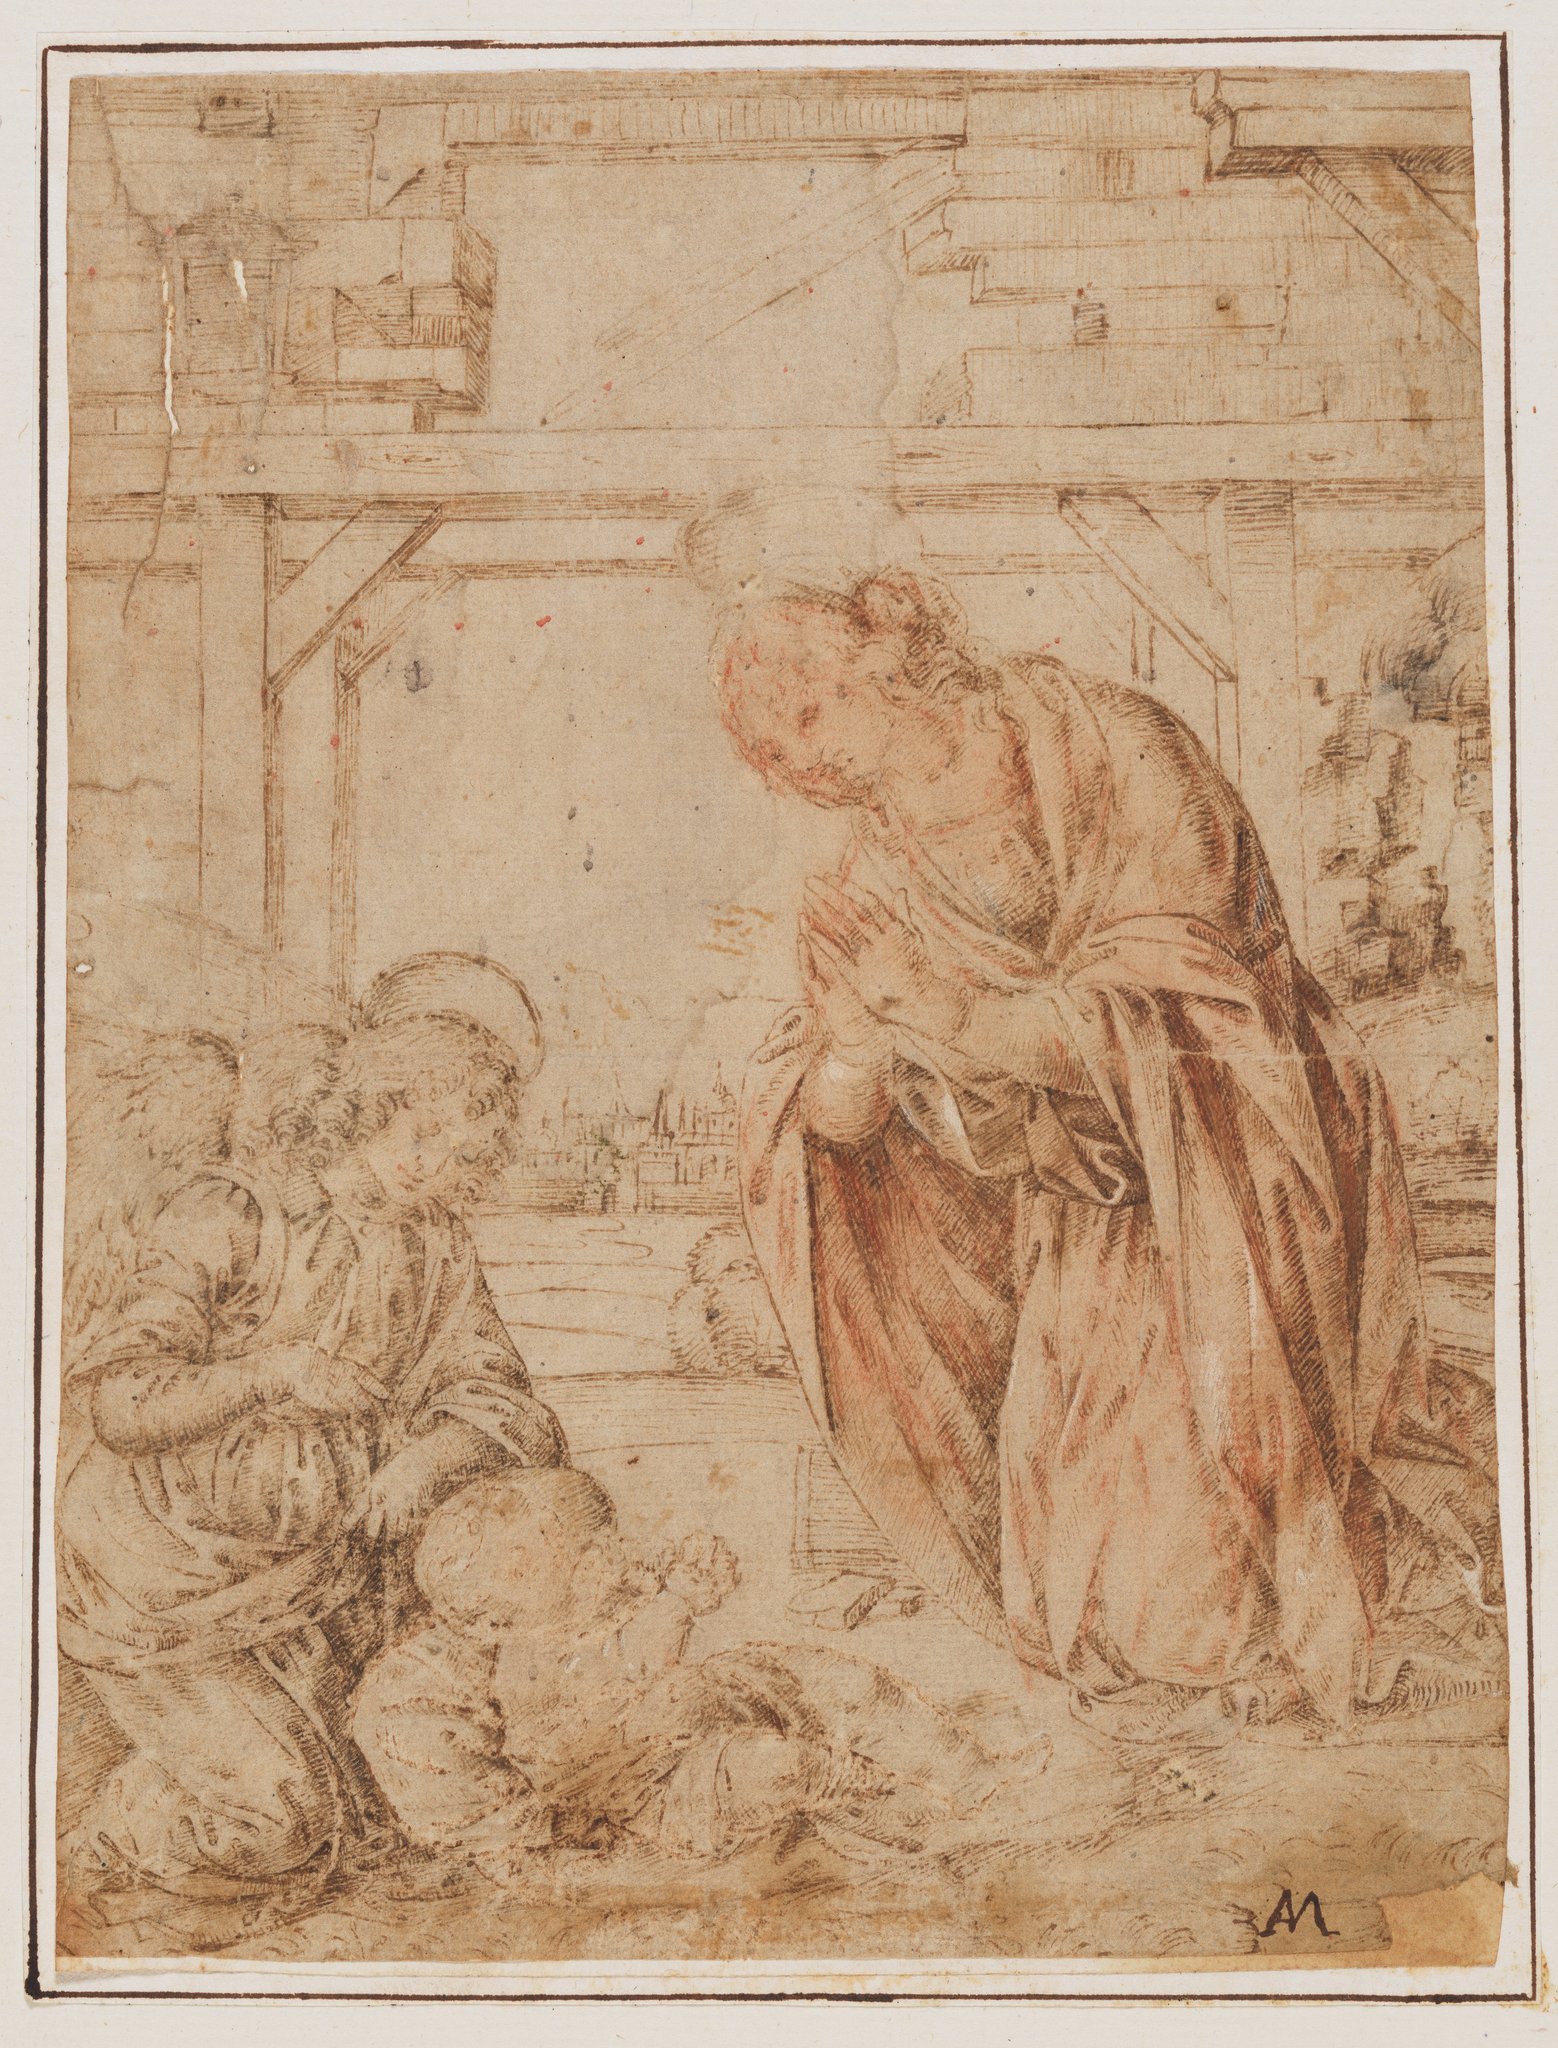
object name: drawing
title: The Madonna Adoring the Child, with an Angel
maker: lorenzo di credi (lorenzo d'andrea d'oderigo)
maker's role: artist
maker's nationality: italian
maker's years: 1456-1536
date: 1501-1533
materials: chalk, ink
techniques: pen, drawing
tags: angels,madonna and child